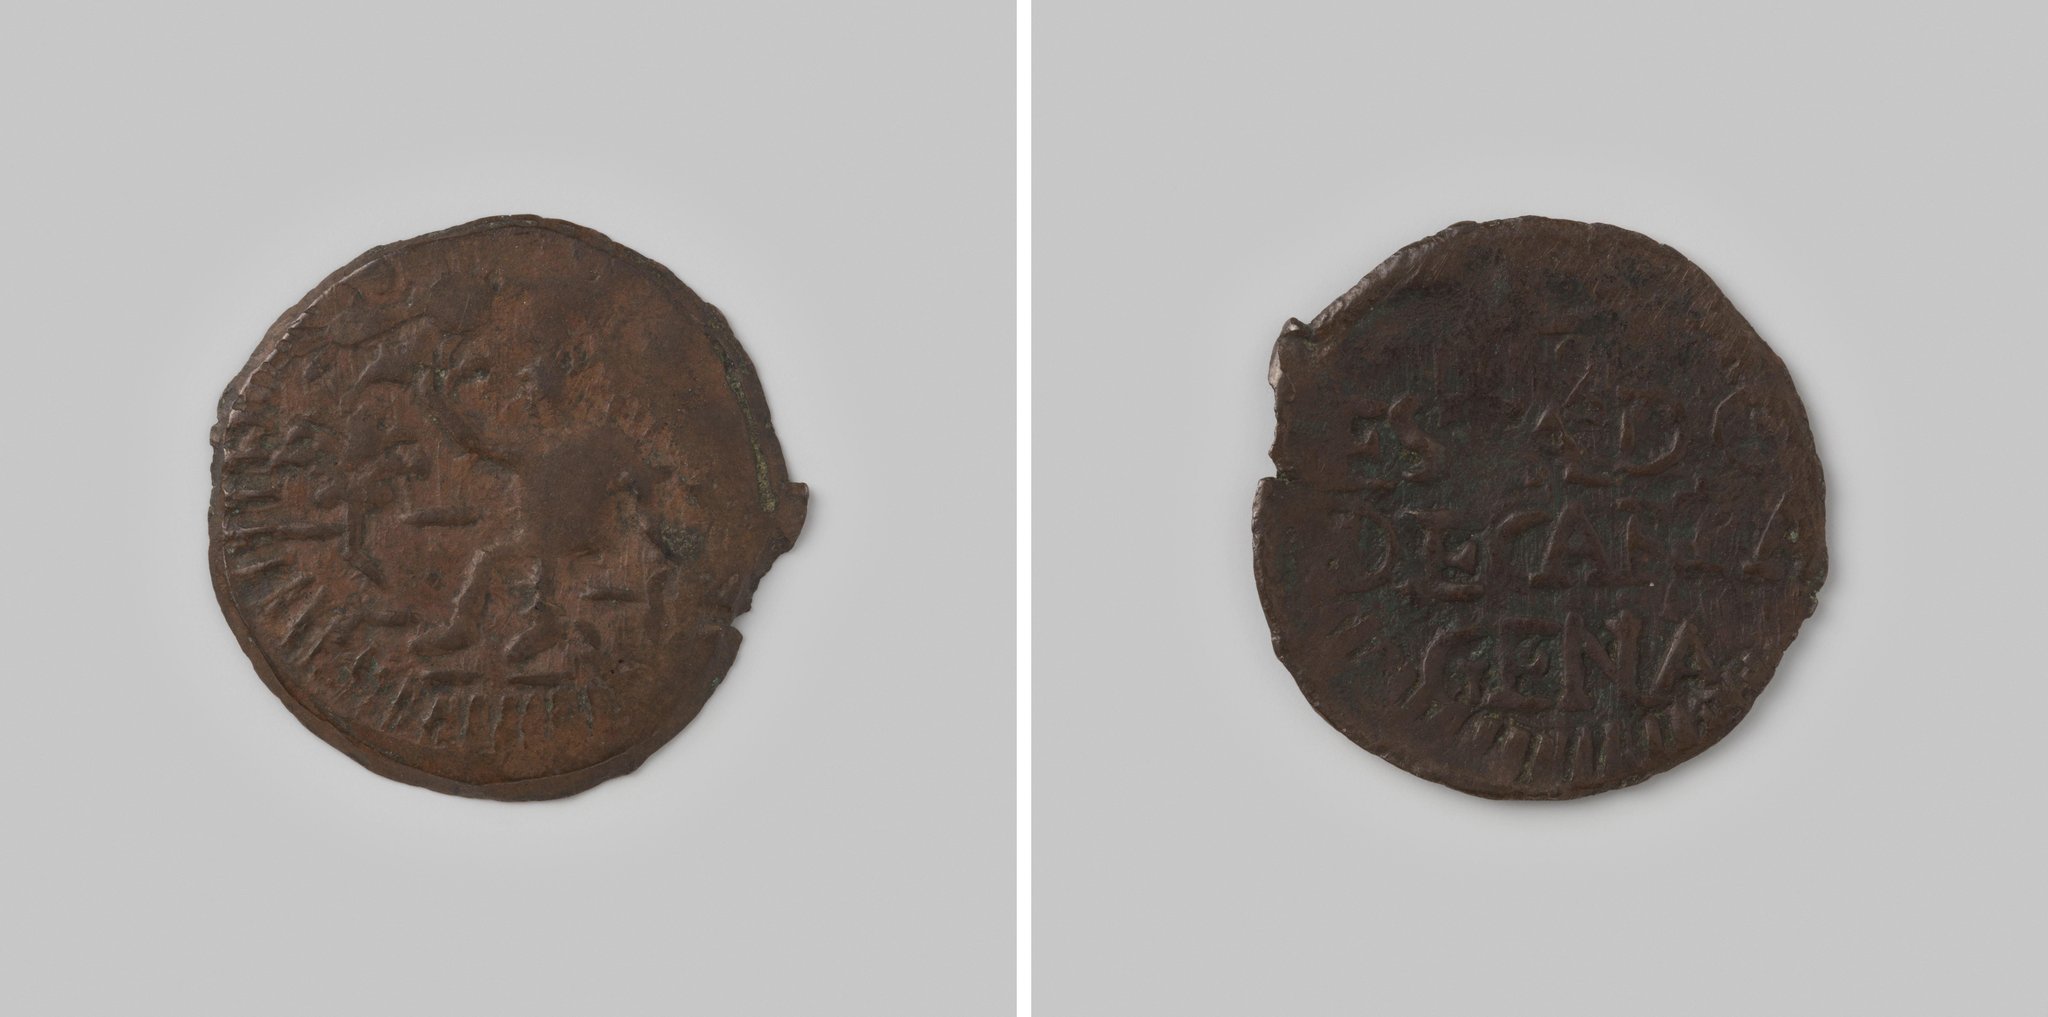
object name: coin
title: Halve reaal, noodmunt uit Cartagena de Indias (Colombia)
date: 1811-1814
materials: copper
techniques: striking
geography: cartagena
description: Koperen noodmunt. Voorzijde: op stoel zittende man naar links met voor zich boom. Keerzijde: bovenaan waarde-aanduiding: ½ op een regel. Daaronder in vier regels plaats-aanduiding: Estado de Carthagena. Noodmunt, geslagen tussen 1811 en 1814.